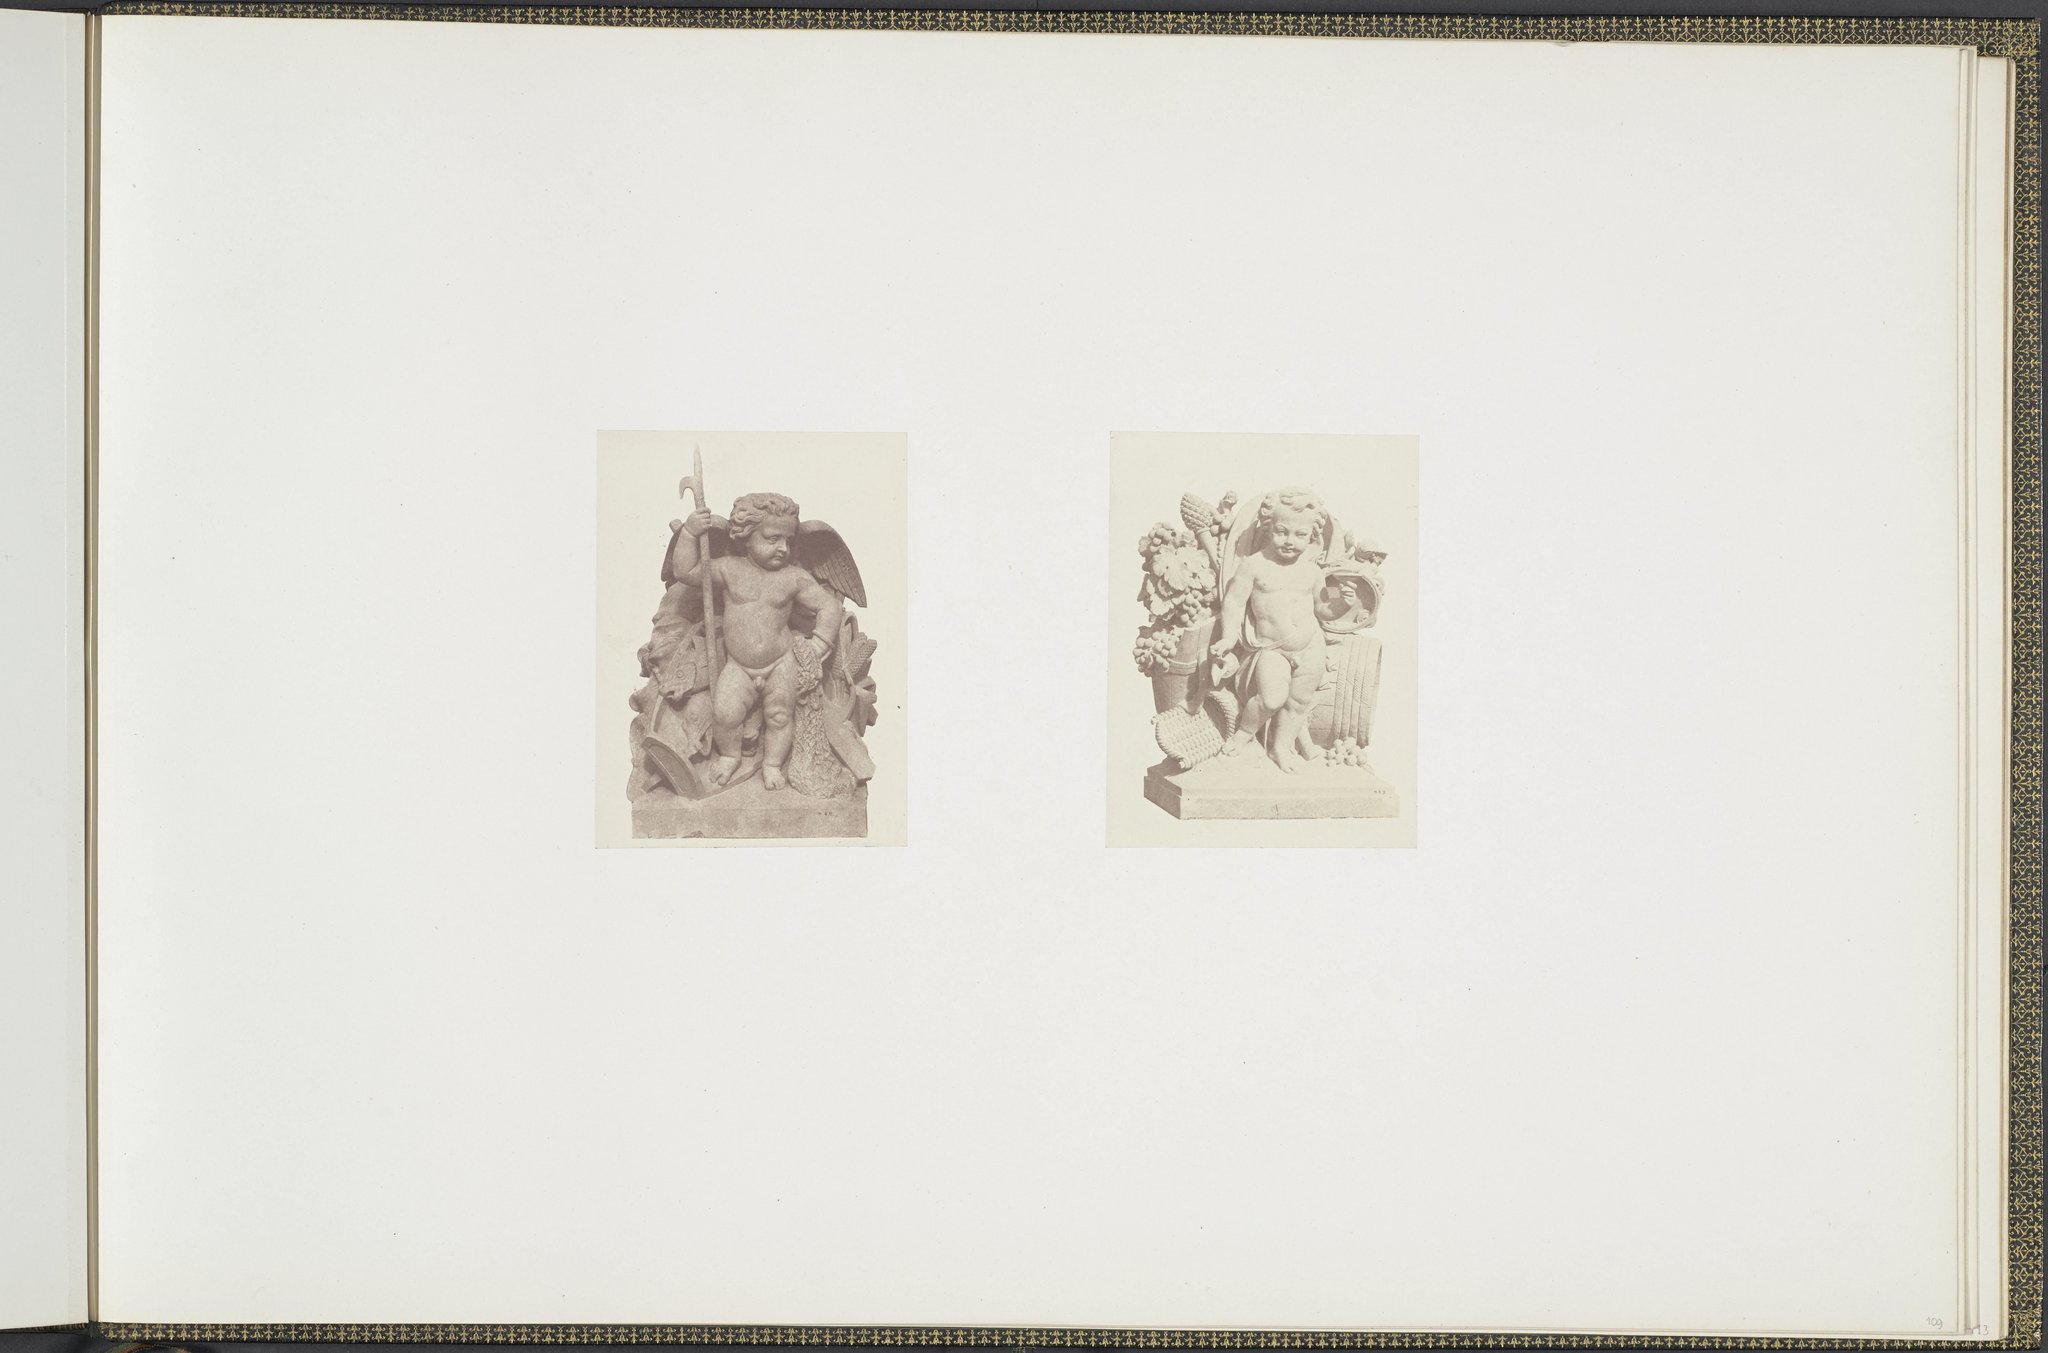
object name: album leaf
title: Gipsmodellen voor beeldhouwwerken op het Palais du Louvre: links "La Pêche" door Auguste Jean Baptiste Lechesne en rechts "La Vendange" door Jacques François Walcher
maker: édouard denis baldus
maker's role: fotograaf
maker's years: 1813-1889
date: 1855-1857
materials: paper, photographic support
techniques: salted paper print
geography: paris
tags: piece of sculpture, reproduction of a piece of sculpture, permanent exhibition, museum, paris, tuileries palace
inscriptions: number: ‘940 en 912’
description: Onderdeel van Réunion des Tuileries au Louvre 1852-1857, album 1.